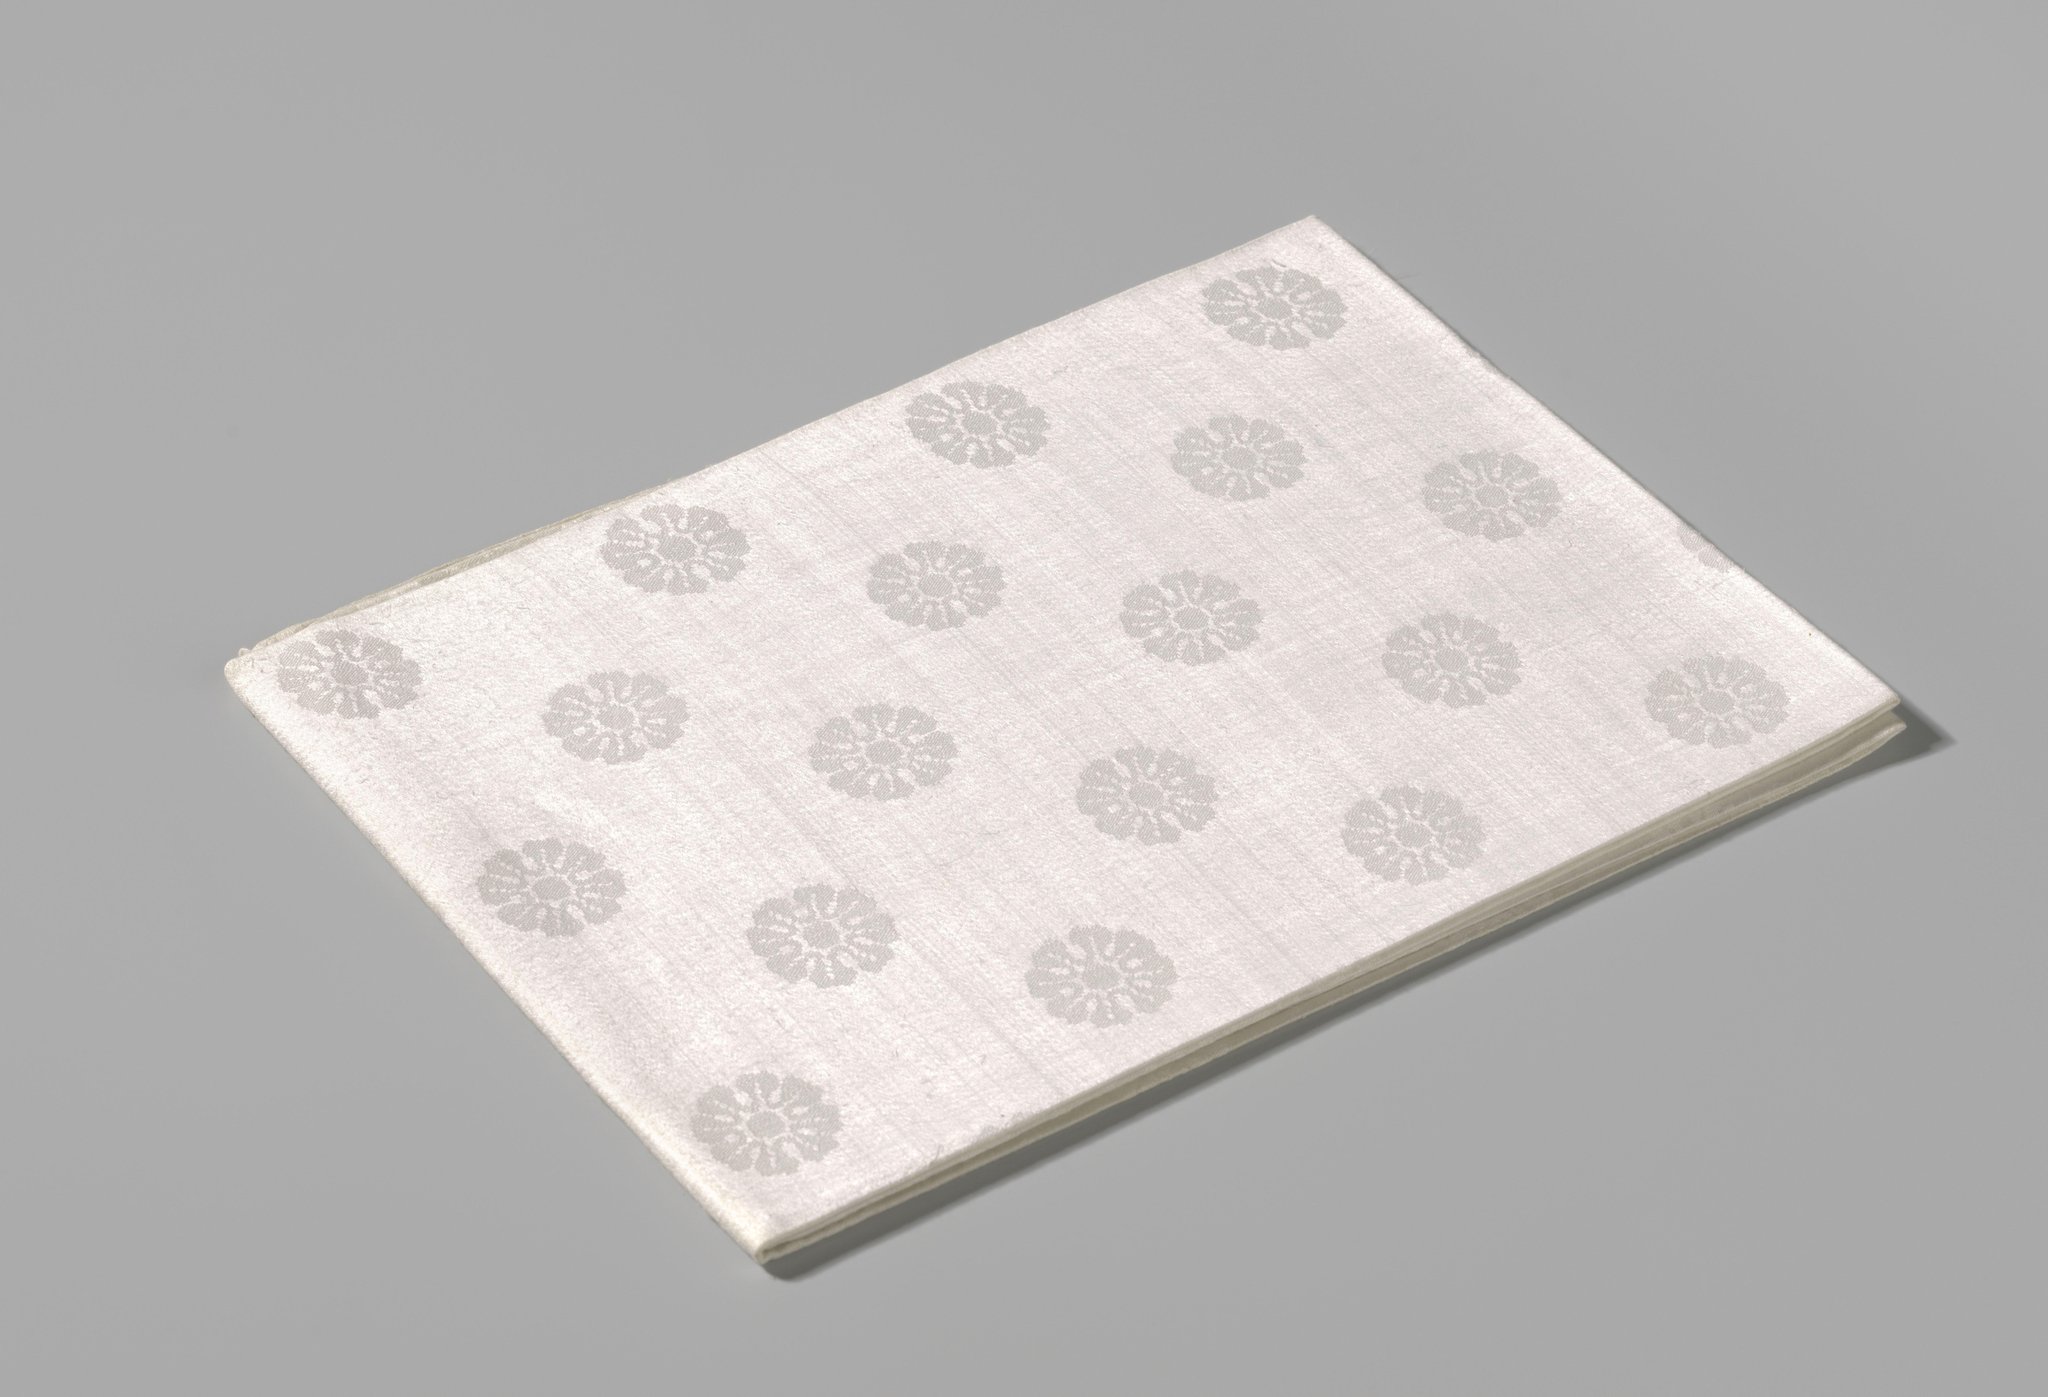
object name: napkin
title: Servet van linnendamast met een bloempatroon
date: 1849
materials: linen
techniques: damask, weave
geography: northern netherlands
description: Servet van linnendamast. Het veld heeft verspringende rijen rozetten en de randen bloemen met acanthusbladeren. De hoeken hebben een vaas met vruchten. Het servet is gemerkt: HW36 1849. Het servet hoort bij dertien servetten (BK-1980-377-A t/m BK-1980-377-N).